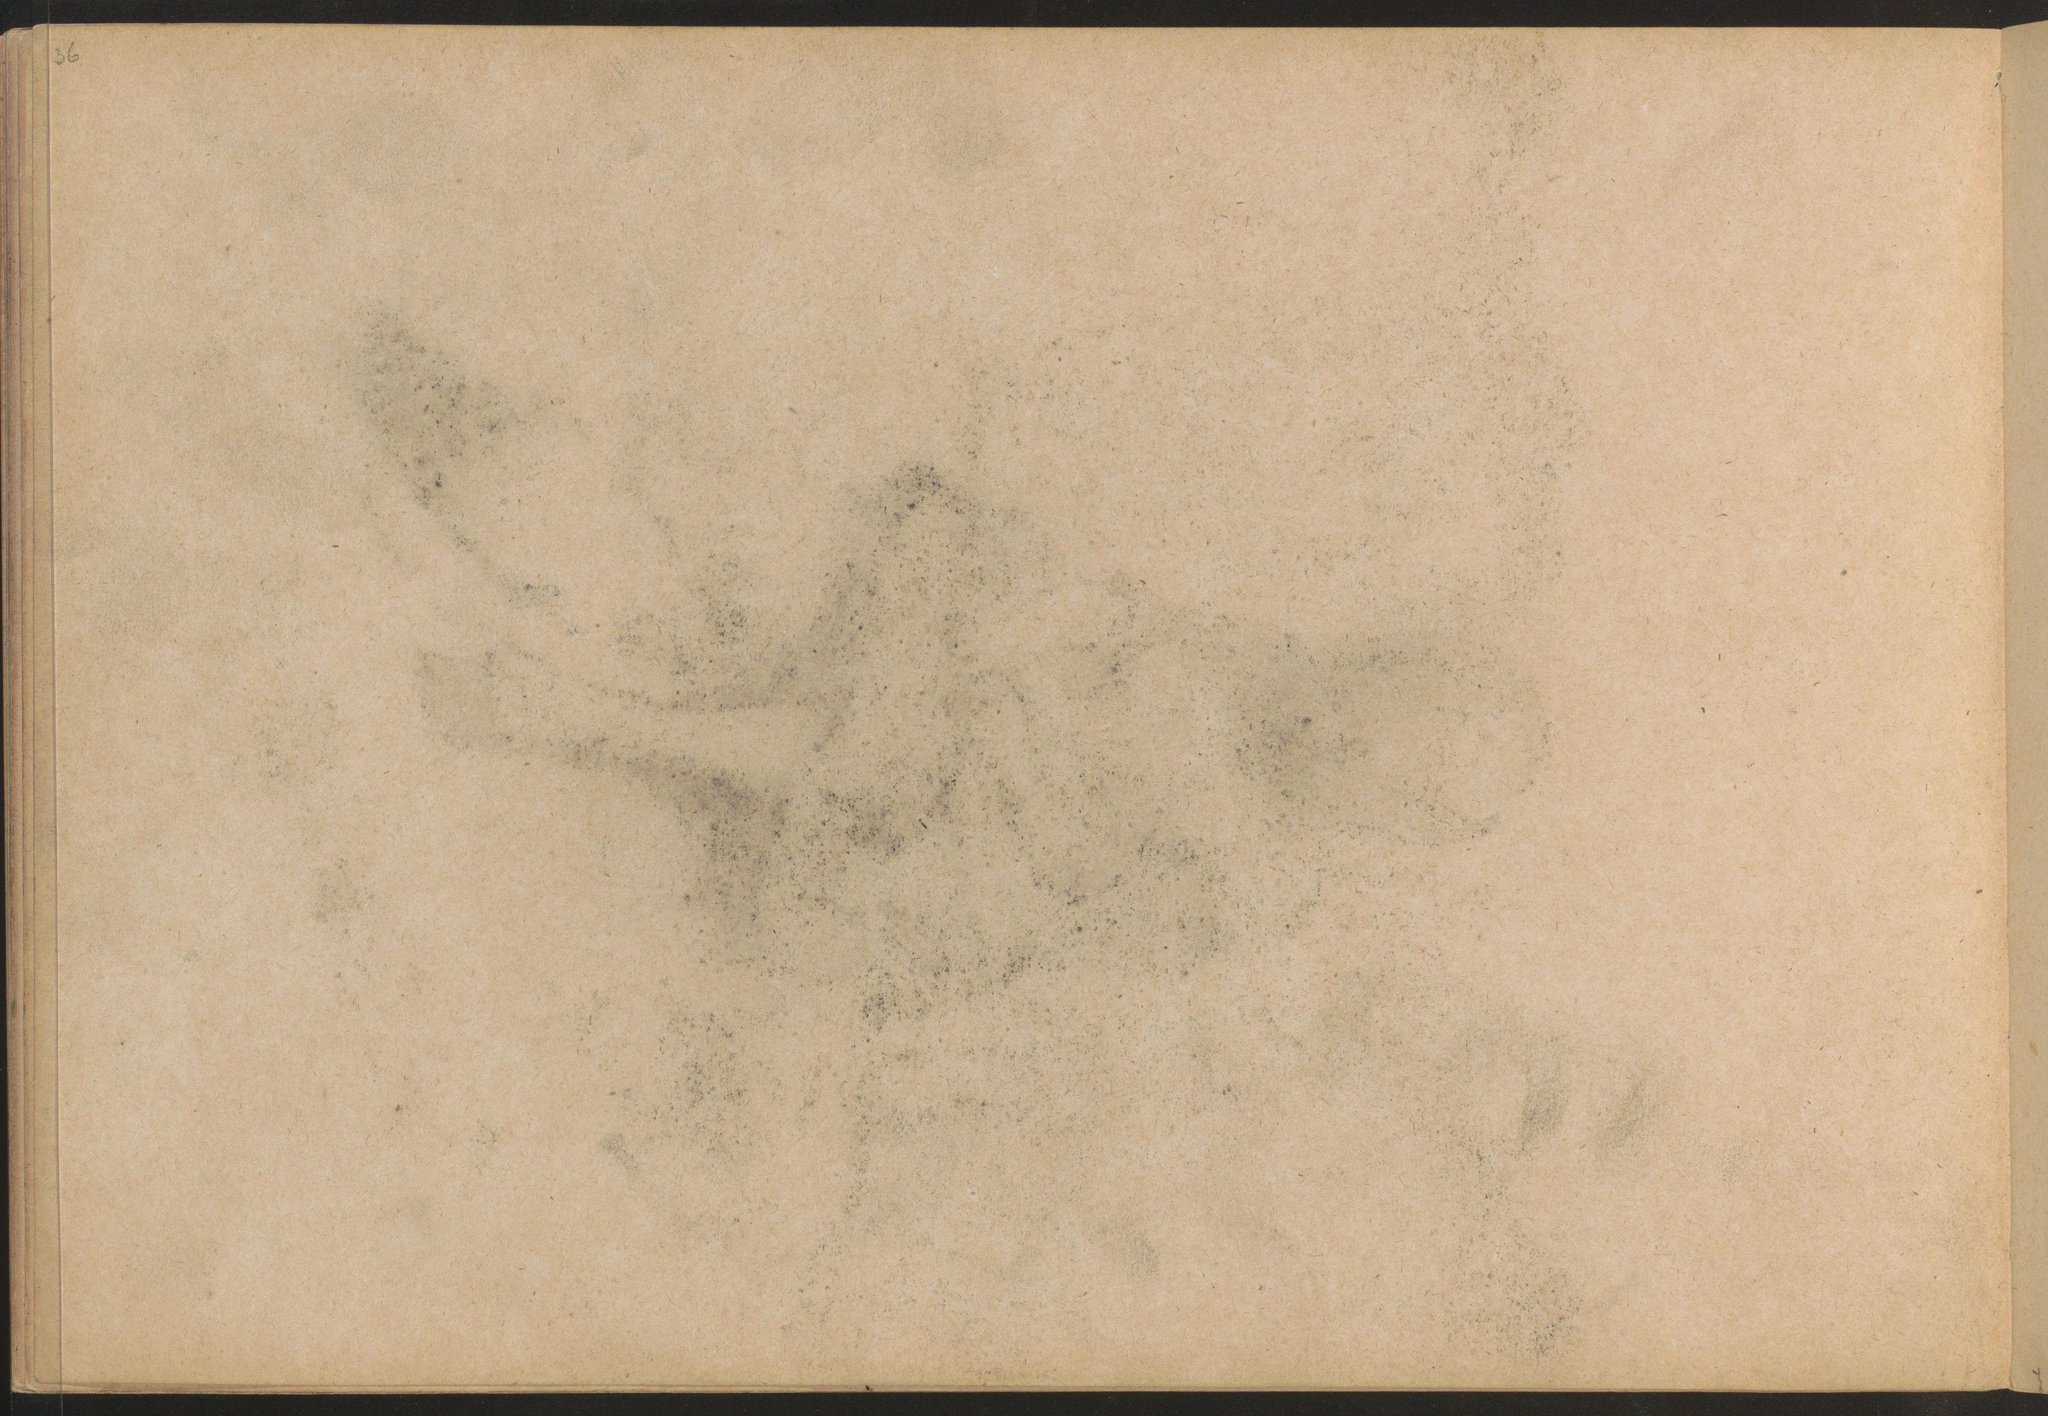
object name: sketchbook leaf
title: Abklatsch van de krijttekening op pagina 37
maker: willem witsen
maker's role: draughtsman, painter, print maker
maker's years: 1860-1923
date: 1884-1887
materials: paper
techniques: printmaking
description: Pagina 36 uit een schetsboek met 29 bladen.